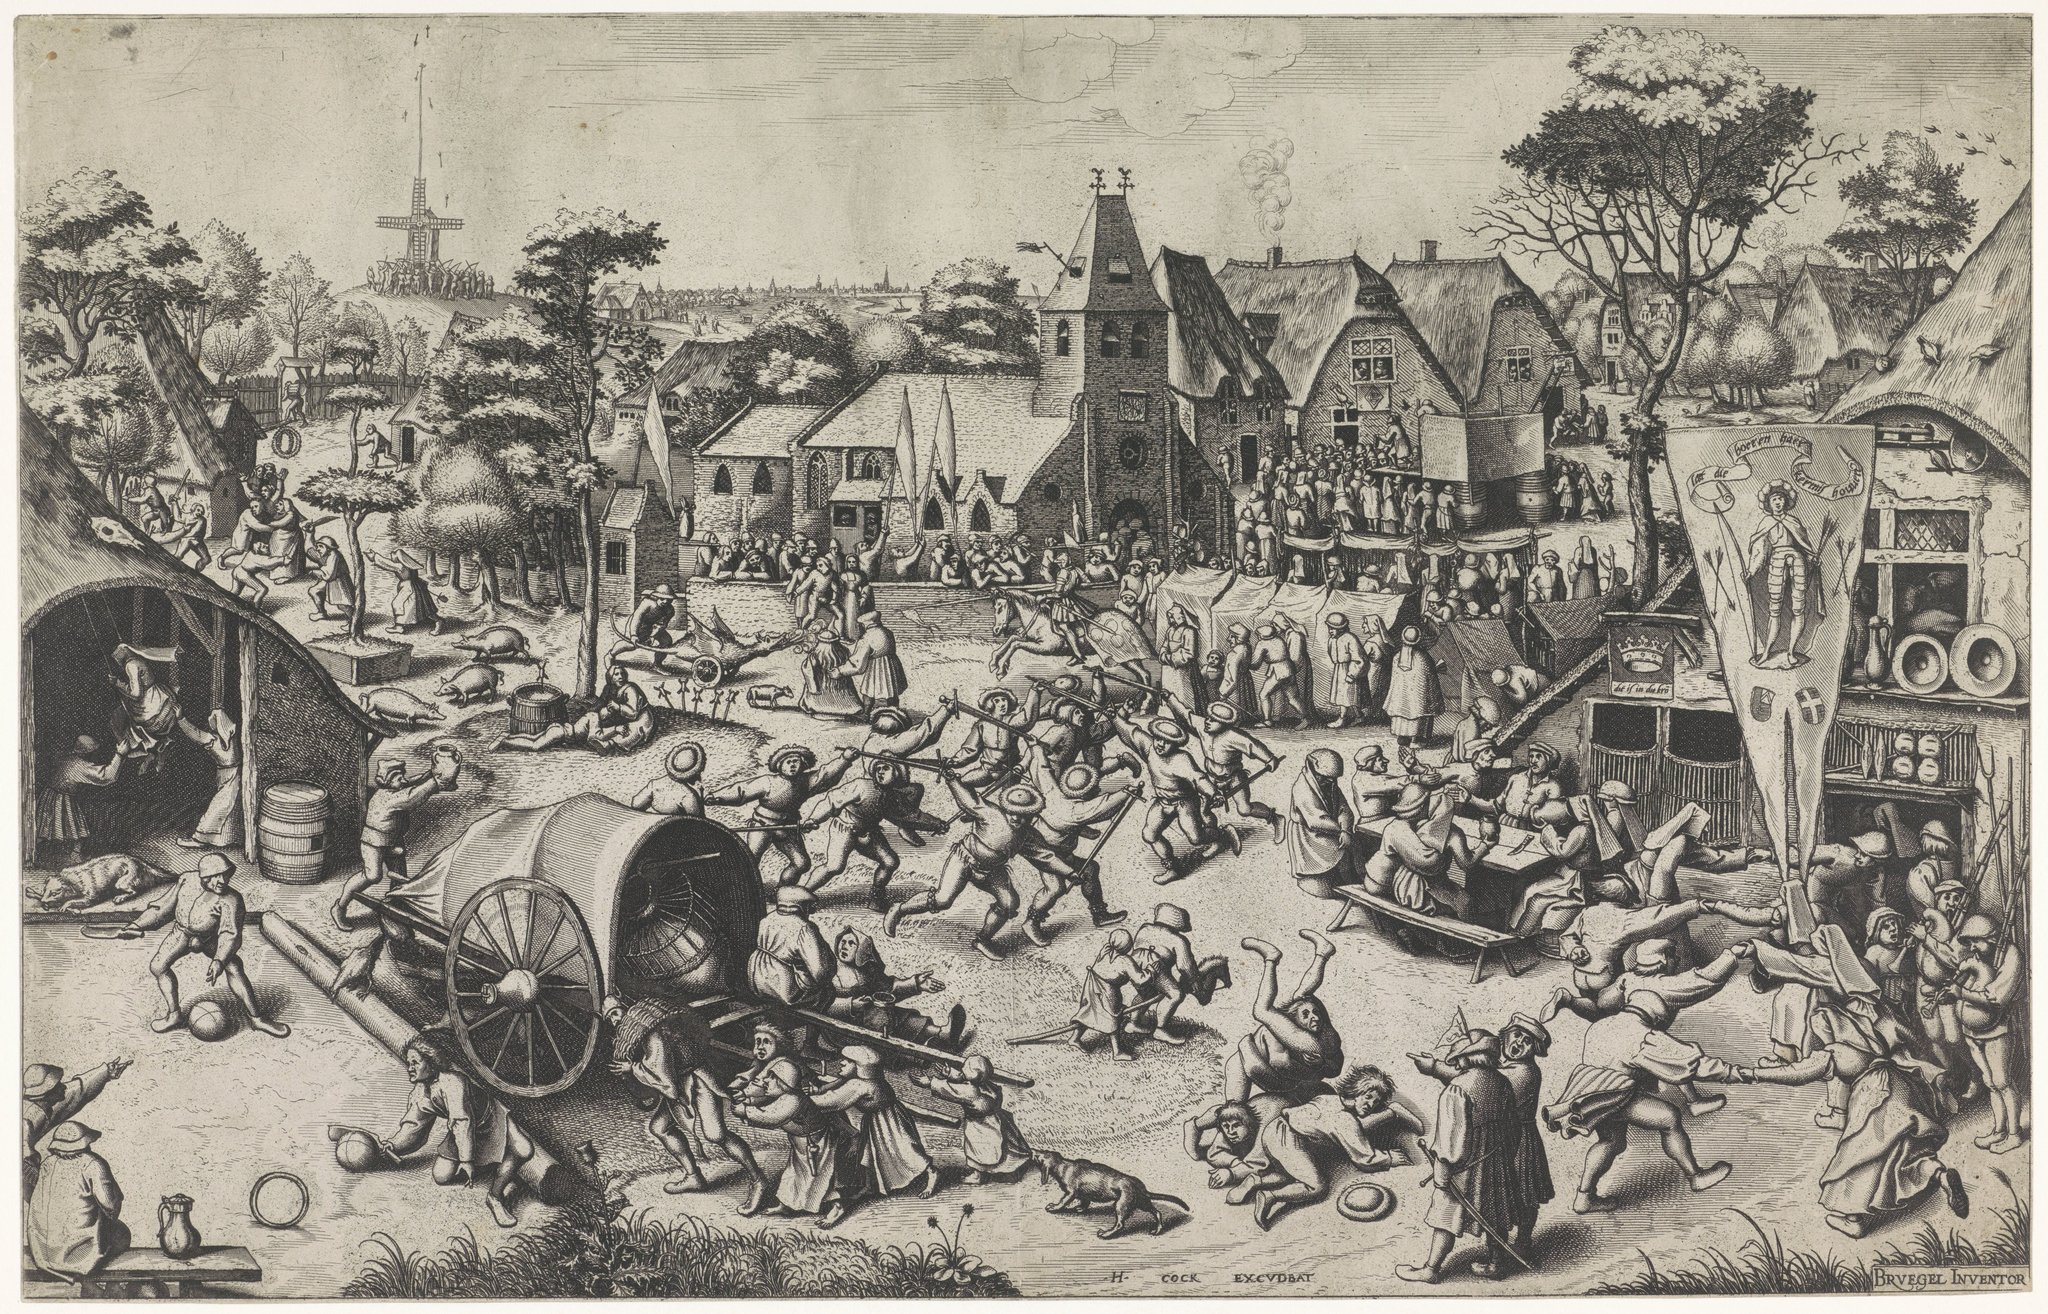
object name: print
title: Kermis van Sint Joris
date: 1557-1561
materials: paper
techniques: engraving, etching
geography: antwerp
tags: (annual) fair, trade fair, pleasure fair and circus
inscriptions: collector's mark: Lugt 240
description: De Sint-Joriskermis. Boerenkermis op het plein in een Vlaamse boerendorp. Rechts een herberg met een vaandel van de schutters van Sint Joris, links een boerenkar. Voor de kerk wordt een toneelscene vertoond waarbij Joris de draak aanvalt. Op de achtergrond rechts een toneelopvoering of een kwakzalver op een verhoging, links schieten op de papegaai bij een molen. Verder veel dansen, muziekmaken, feesten, eten en drinken en vechten.